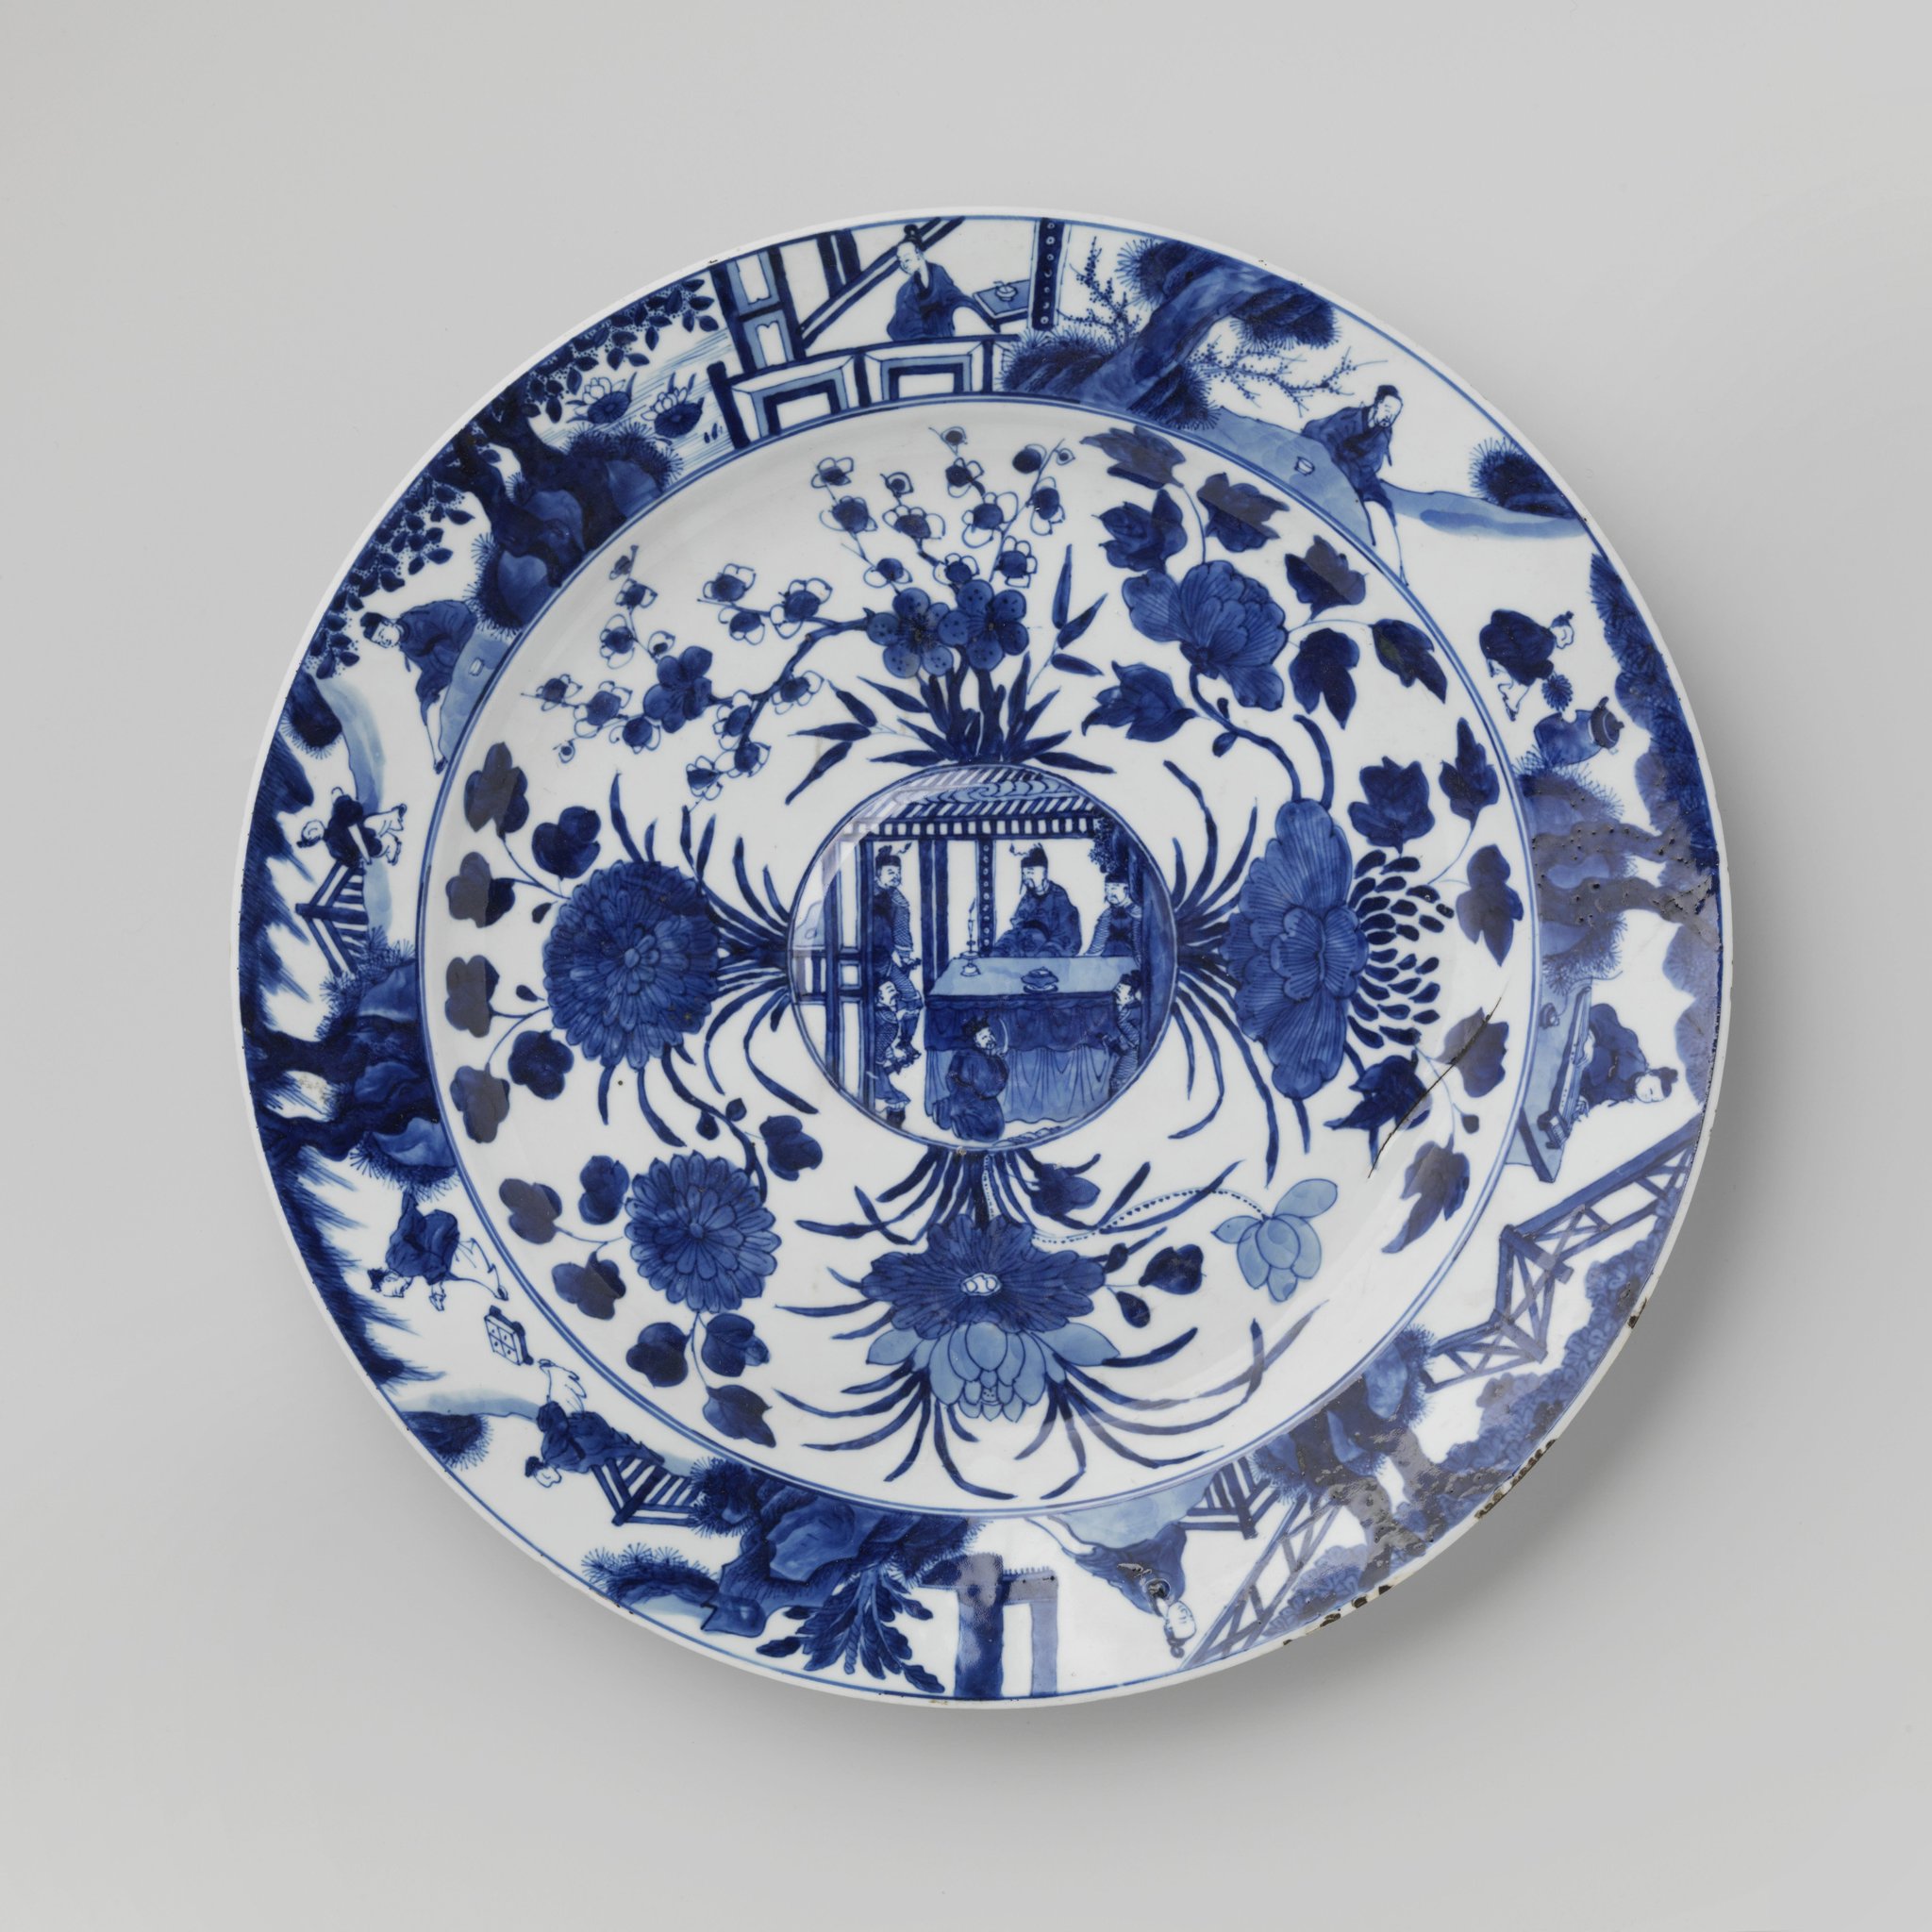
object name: platter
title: Dish with flower sprays and figures in an interior and in a landscape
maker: Anonymous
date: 1700-1724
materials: cobalt, glaze, paint, porcelain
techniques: firing, turning, vitrification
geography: china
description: Schotel, op bolle plat bloemen en mannen rond een tafel, rand; figuren in- en buitenshuis.